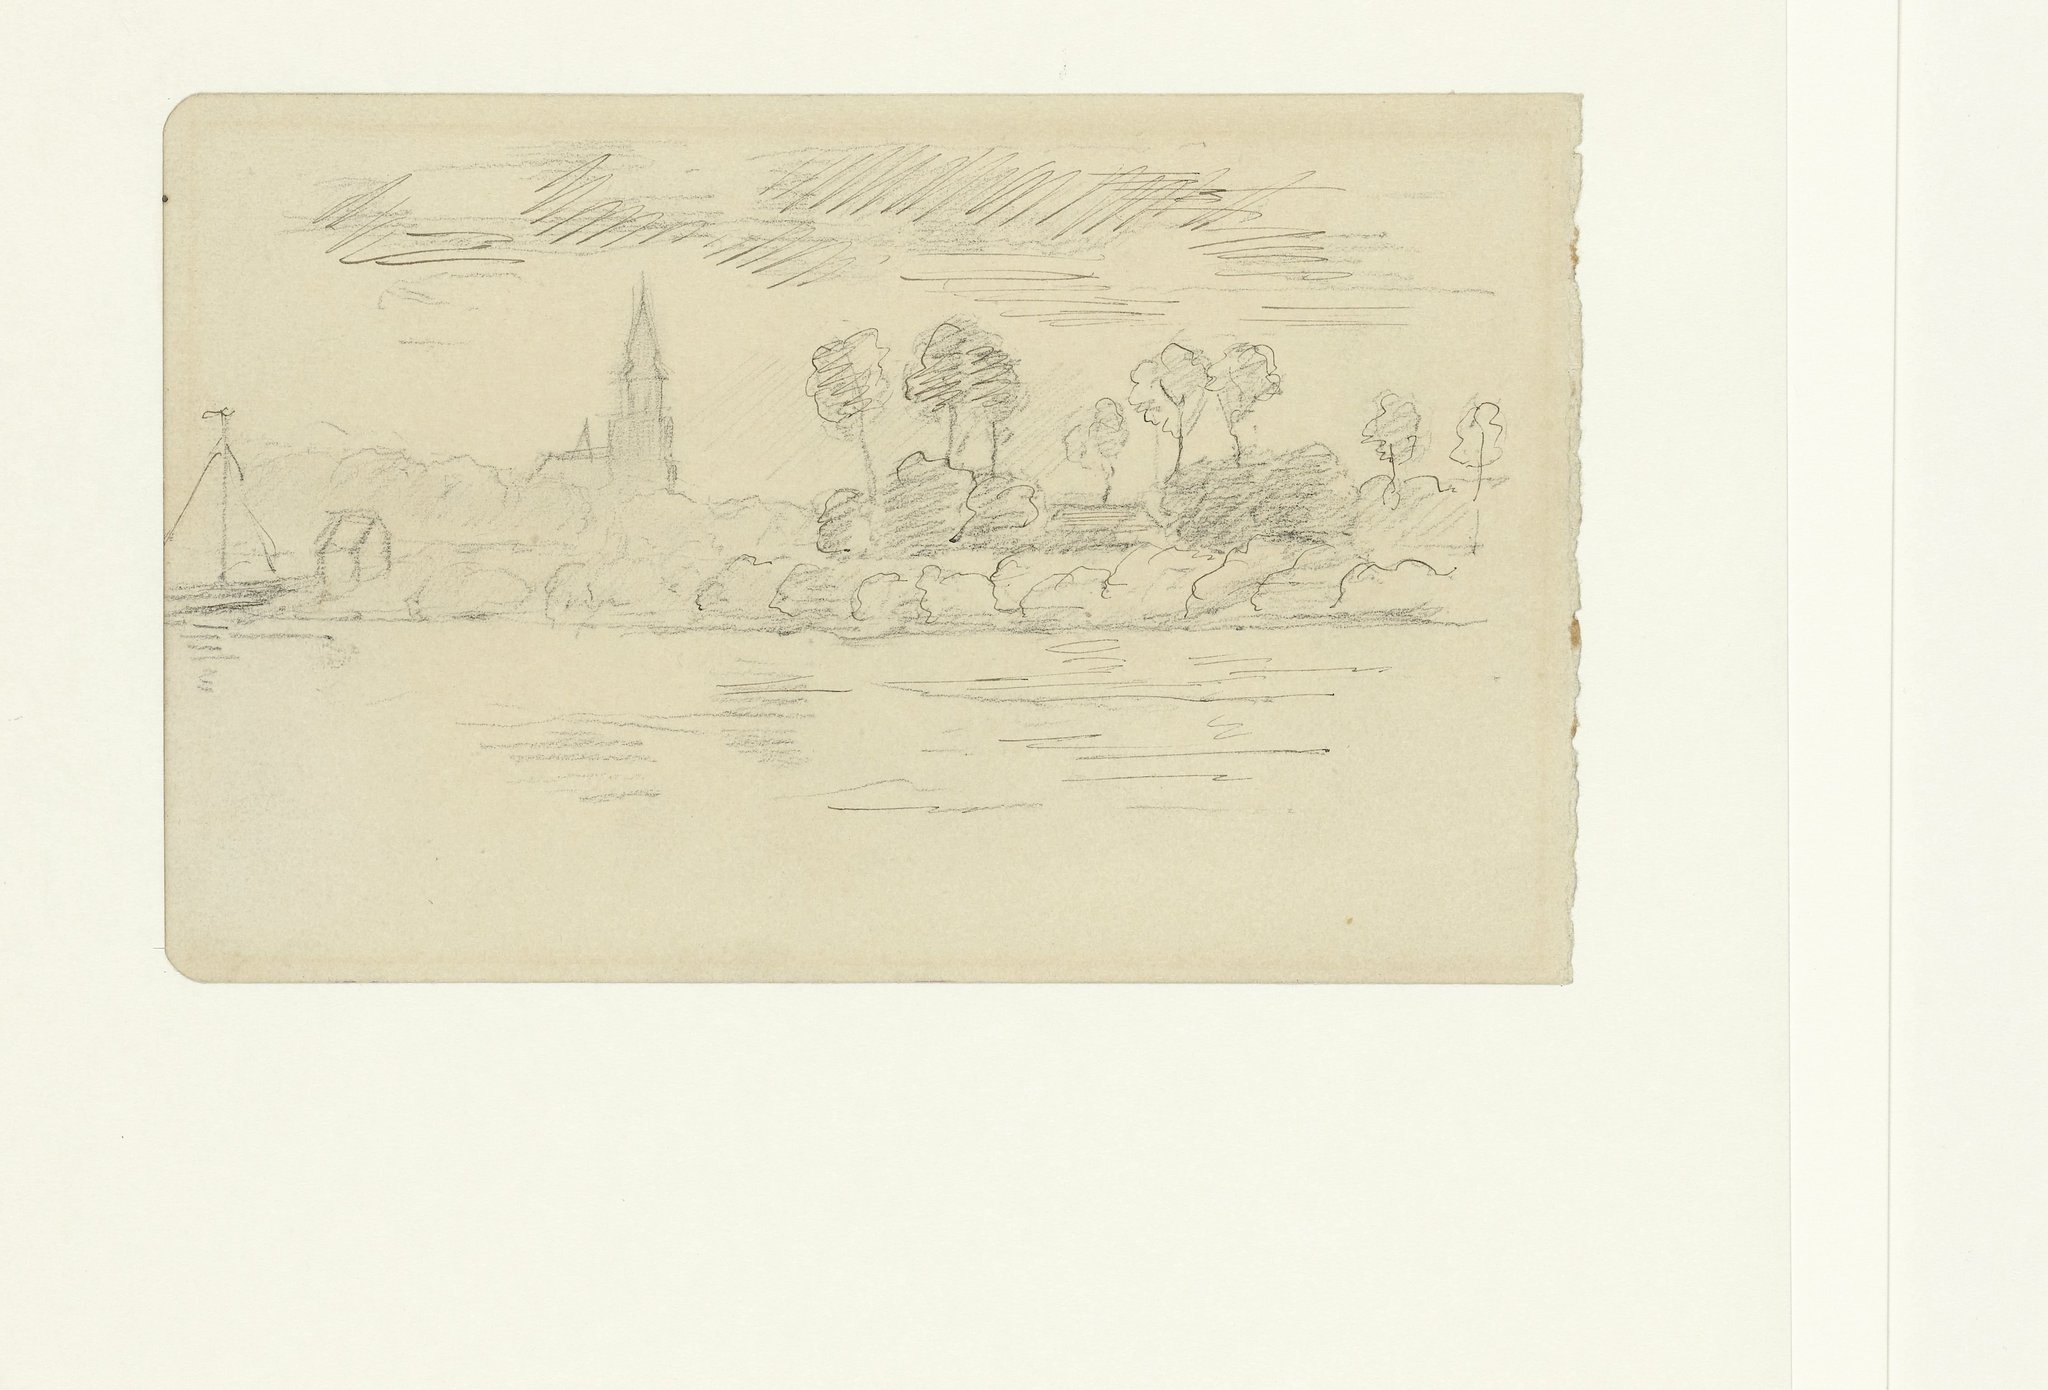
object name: drawing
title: Kerk tussen bomen aan het water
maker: jozef israëls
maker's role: draughtsman, painter, print maker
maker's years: 1824-1911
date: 1834-1911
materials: chalk, ink, paper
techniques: pen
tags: river